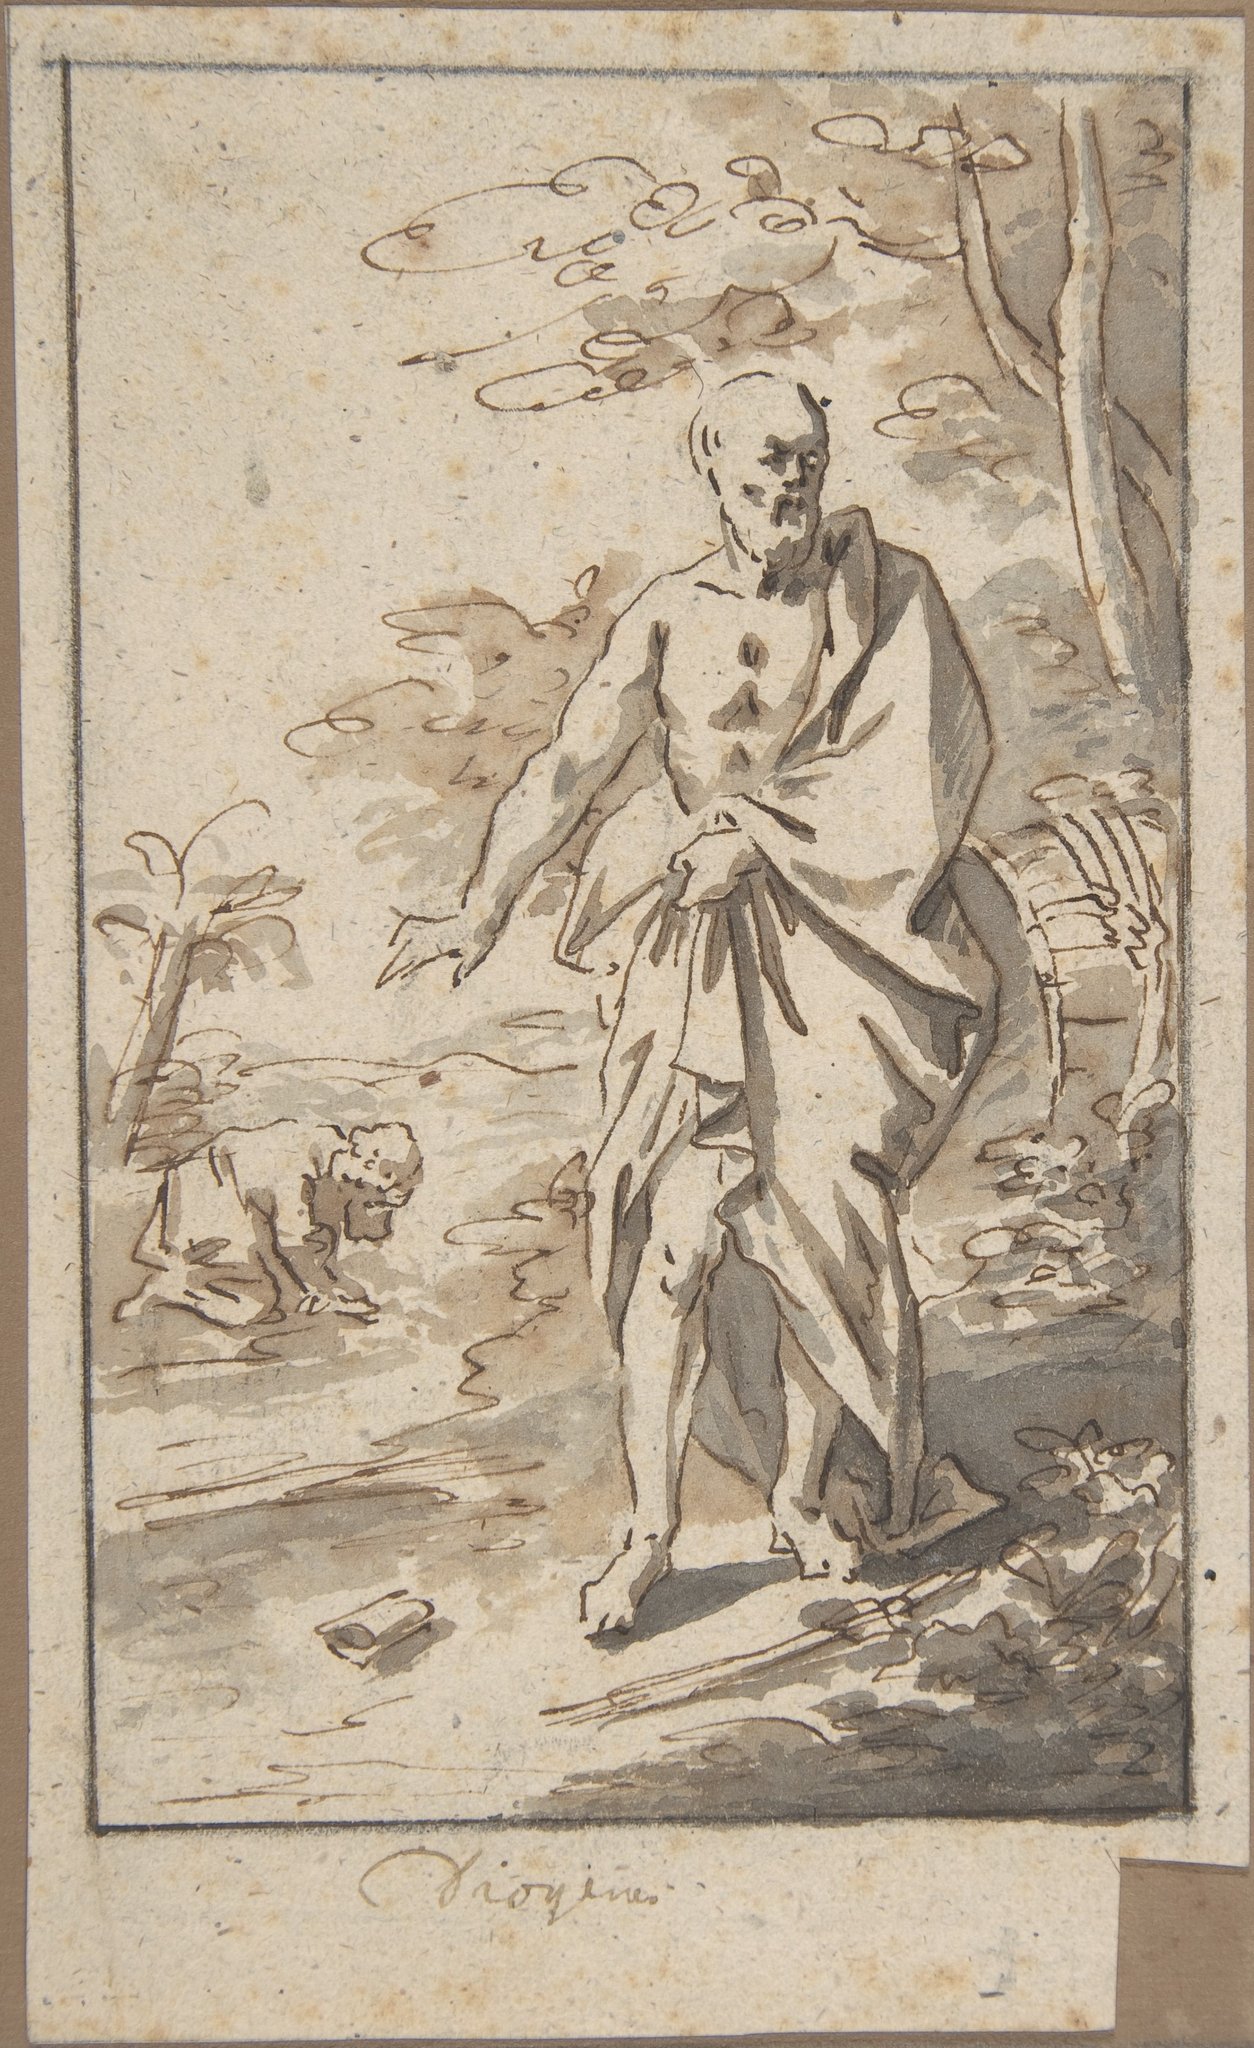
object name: drawing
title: Diogenes Throwing His Cup to the Ground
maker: anonymous, french, 17th century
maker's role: artist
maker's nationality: french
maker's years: 1600-1700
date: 1601-1700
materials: graphite, ink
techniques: brush, pen, wash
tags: diogenes,cups